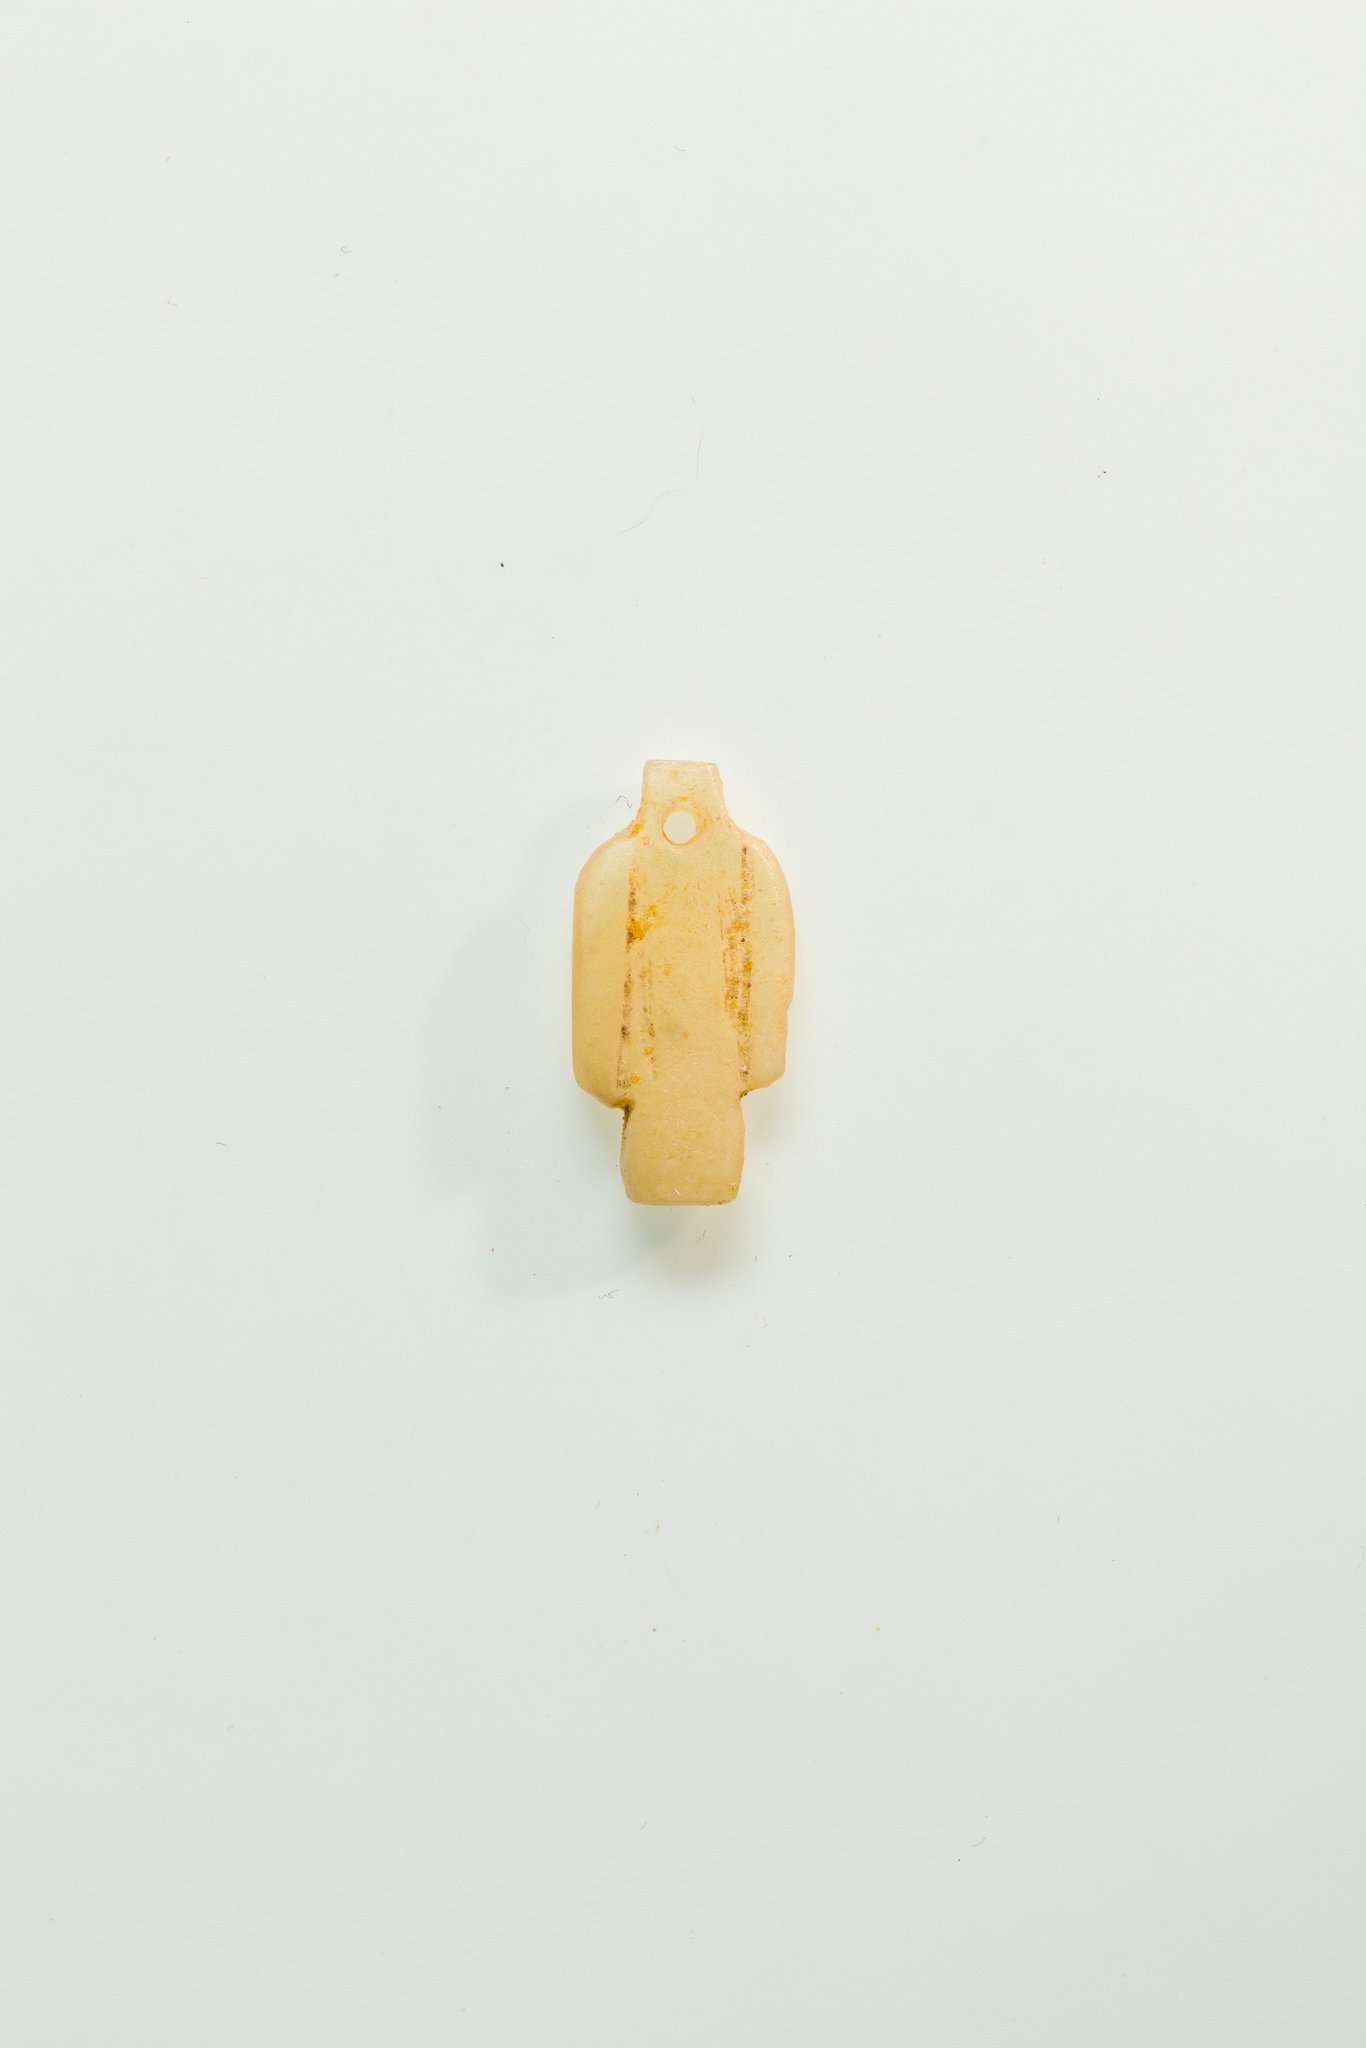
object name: amulet, tit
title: Tit (Isis knot) from string of amulets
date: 1070-945 BCE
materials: gemstone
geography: egypt